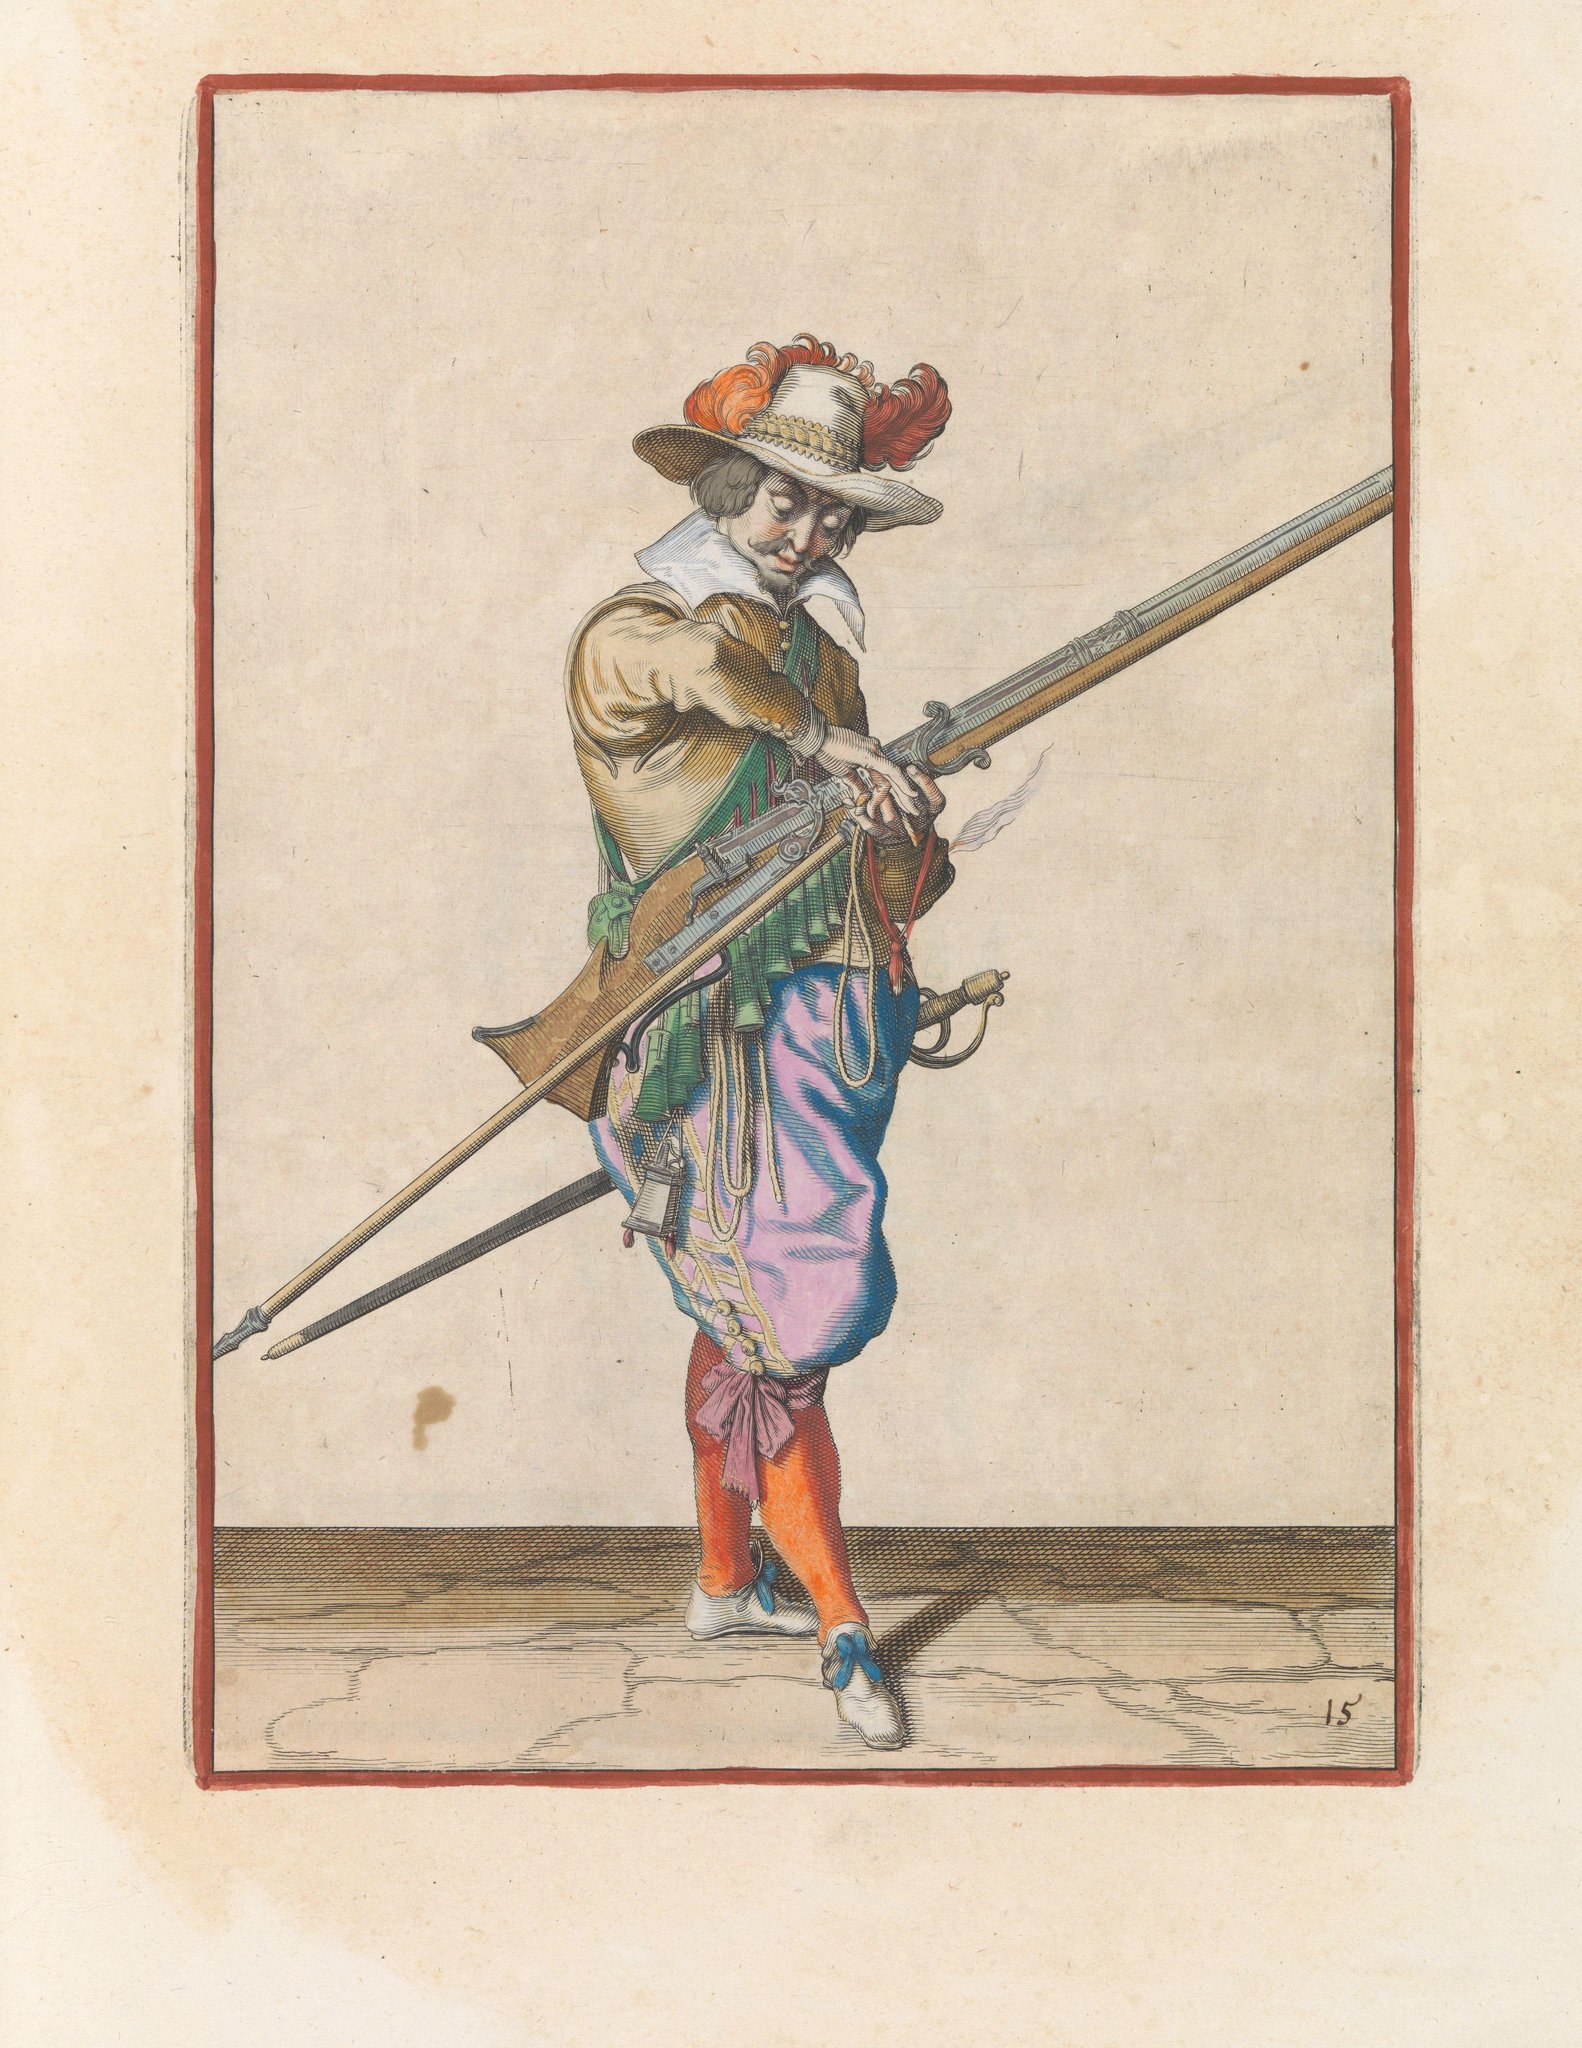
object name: print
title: Soldaat met een musket die zijn lont overbrengt van zijn rechter- naar zijn linkerhand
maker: jacques de gheyn (ii)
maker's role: painter, print maker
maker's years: 1565-1629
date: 1597-1607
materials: paper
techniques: engraving, hand coloring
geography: the hague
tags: handling of weapons ~ military training, firearms: rifle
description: Een soldaat, ten voeten uit, naar rechts, die een musket (een bepaald type vuurwapen) en een furket (musketvork) met zijn linkerhand vasthoudt. De brandende lont in zijn rechterhand brengt hij over naar zijn linkerhand. Deze prent is onderdeel van de reeks van 43 met de hand genummerde prenten van musketiers in de Wapenhandelinghe.